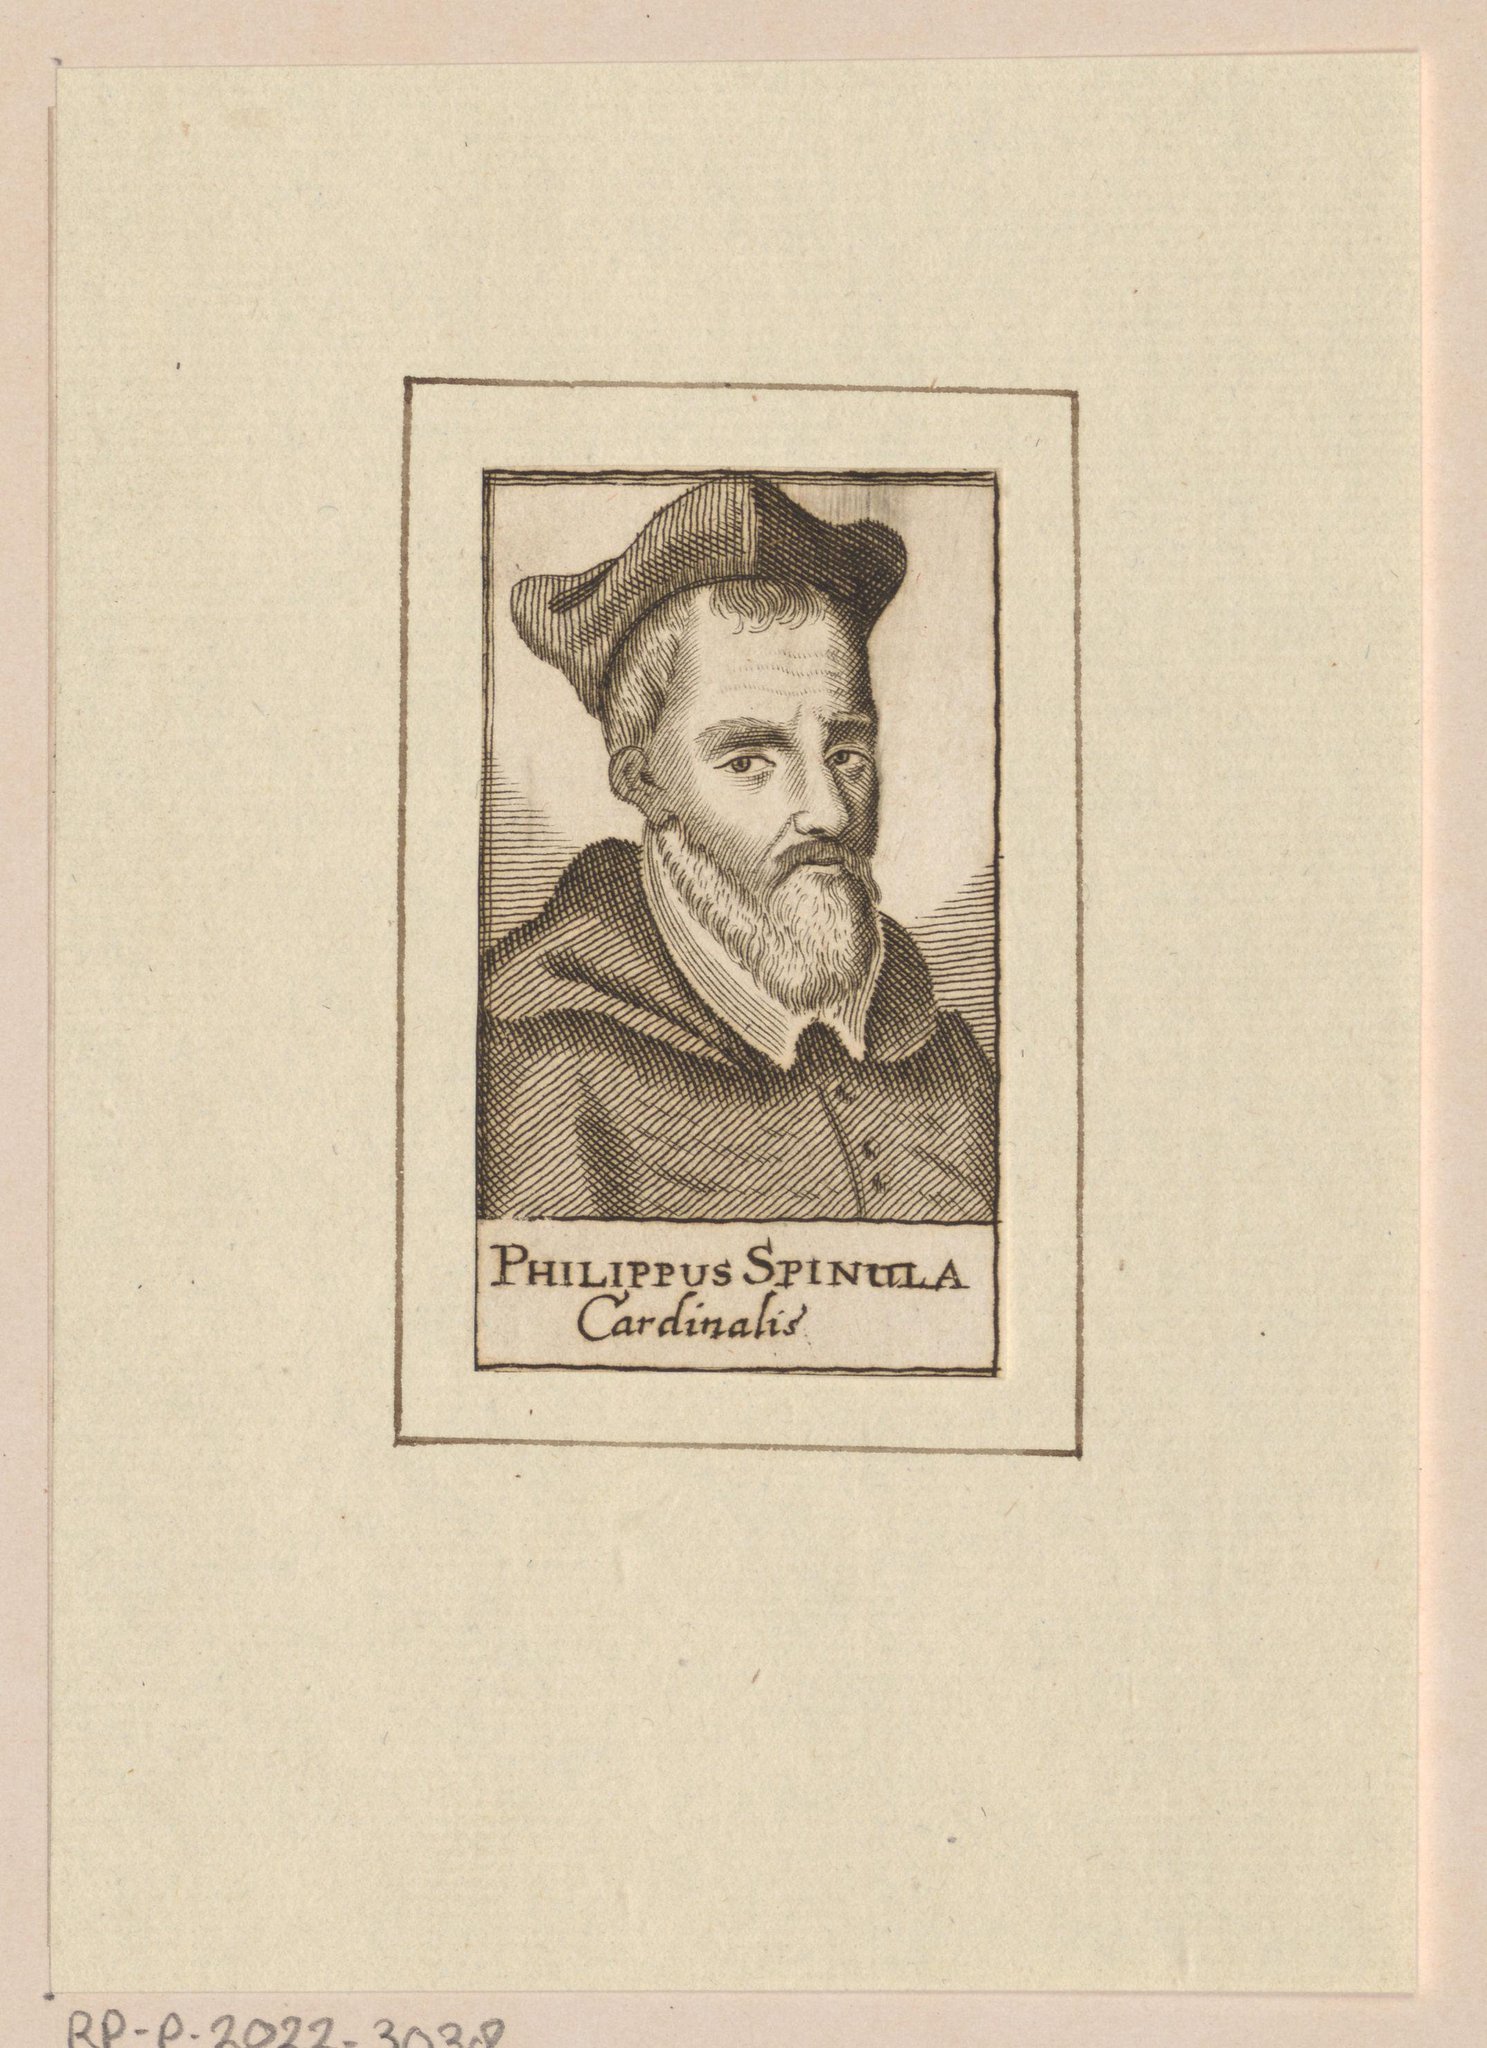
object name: print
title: Portret van Ambrogio Spinola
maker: Anonymous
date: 1688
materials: ink, paper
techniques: engraving, pen, snipping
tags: commander-in-chief, general, marshal, historical persons, knighthood order of the golden fleece - insignia of a knighthood order, e.g.: badge, chain (with name of order)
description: Prent uit: Freher, Paul. Theatrum virorum eruditione clarorum. Neurenberg: Johann Hoffmann, 1688.